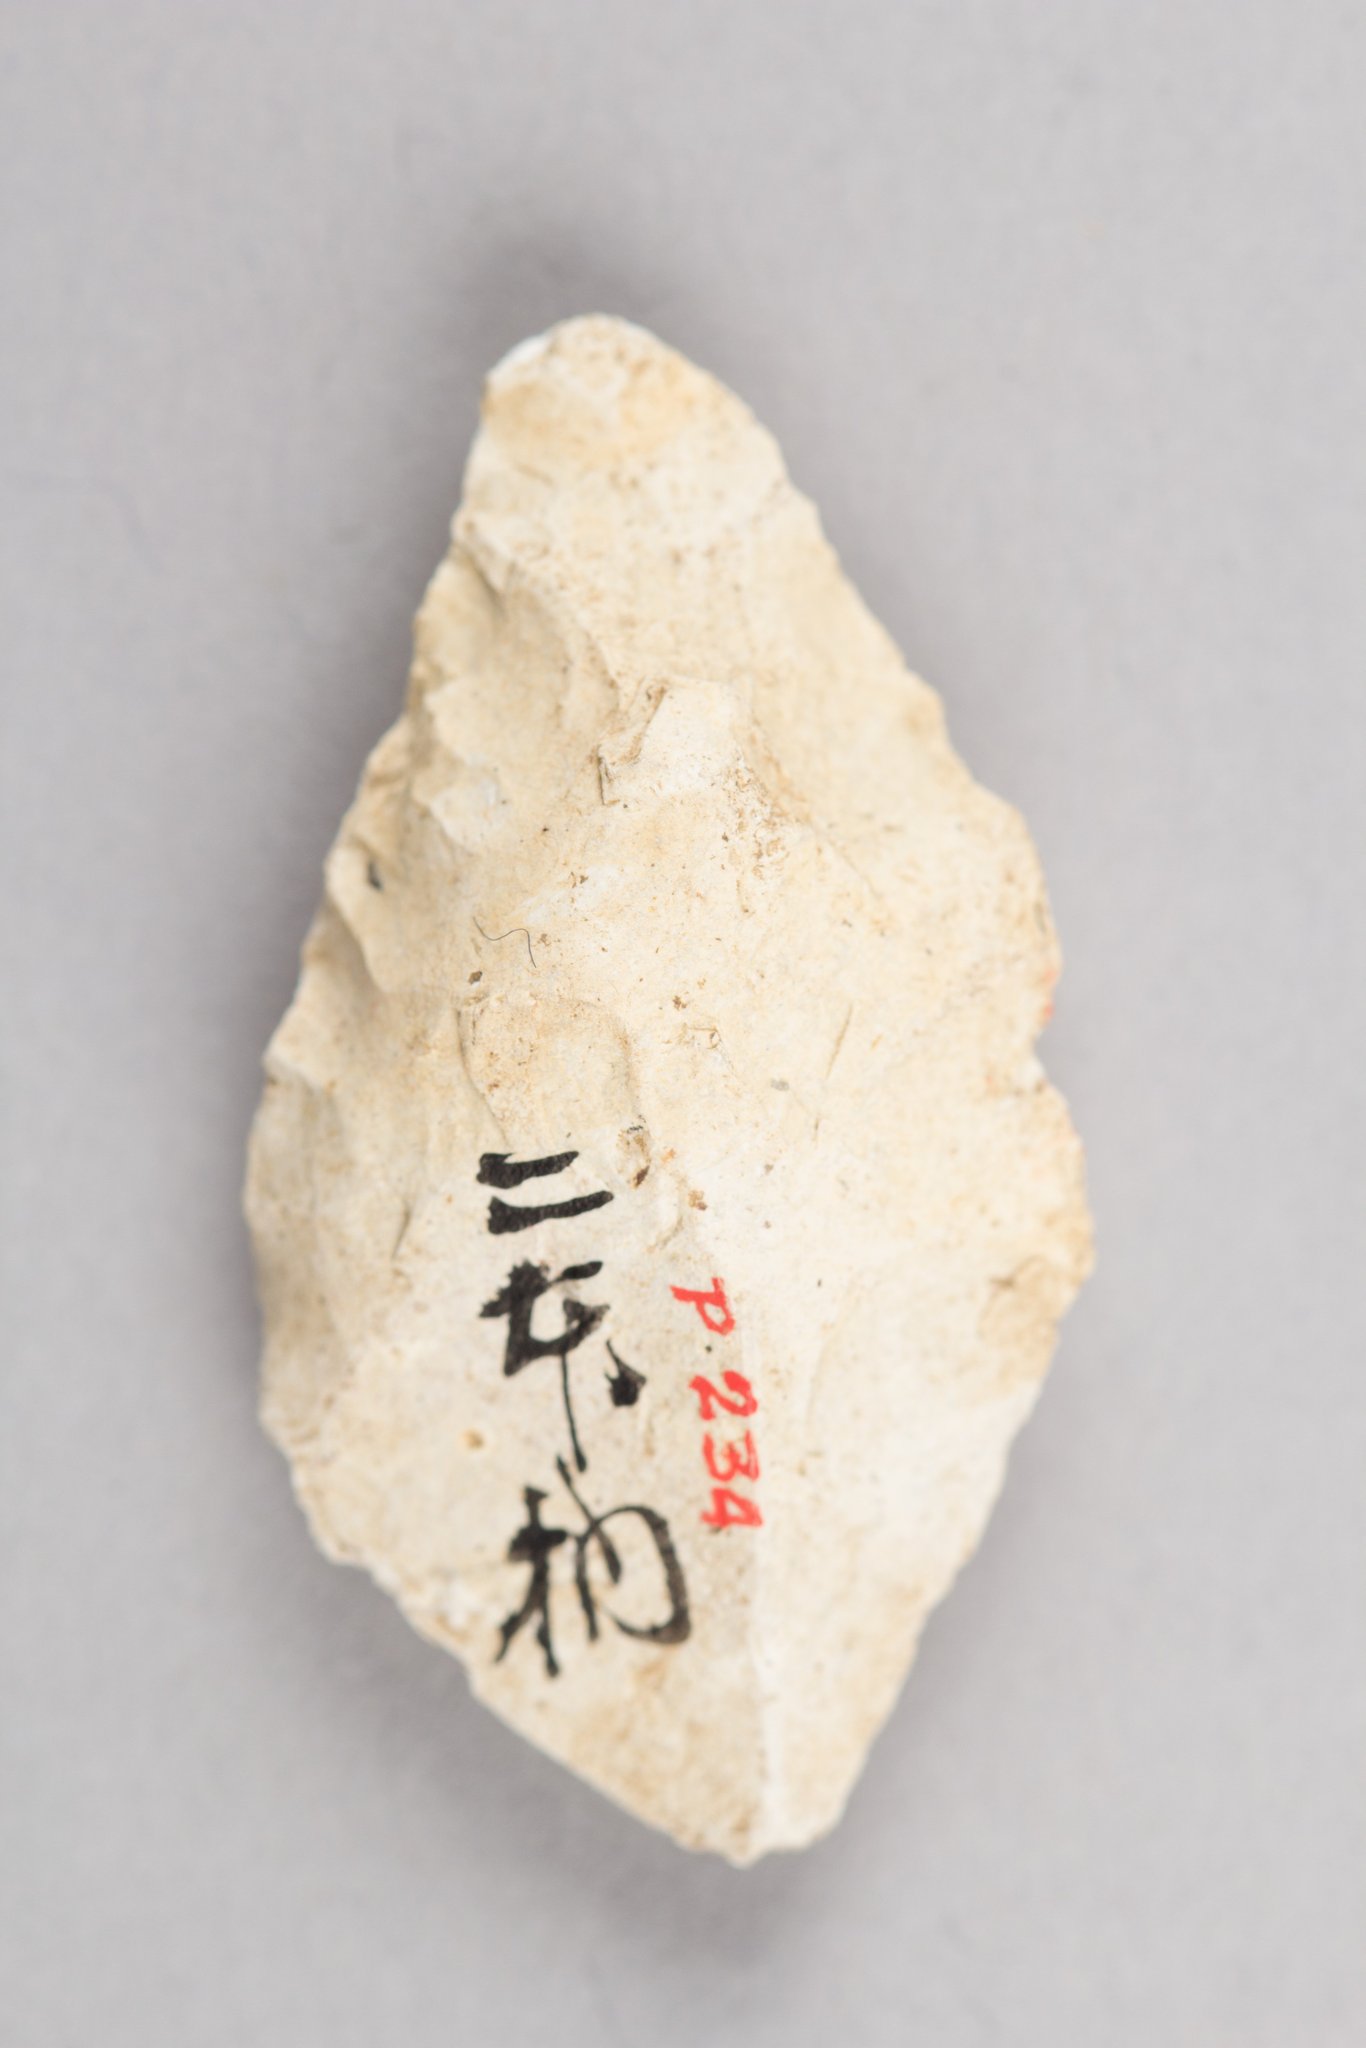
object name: arrowhead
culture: japanese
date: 1500-1000 BCE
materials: stone